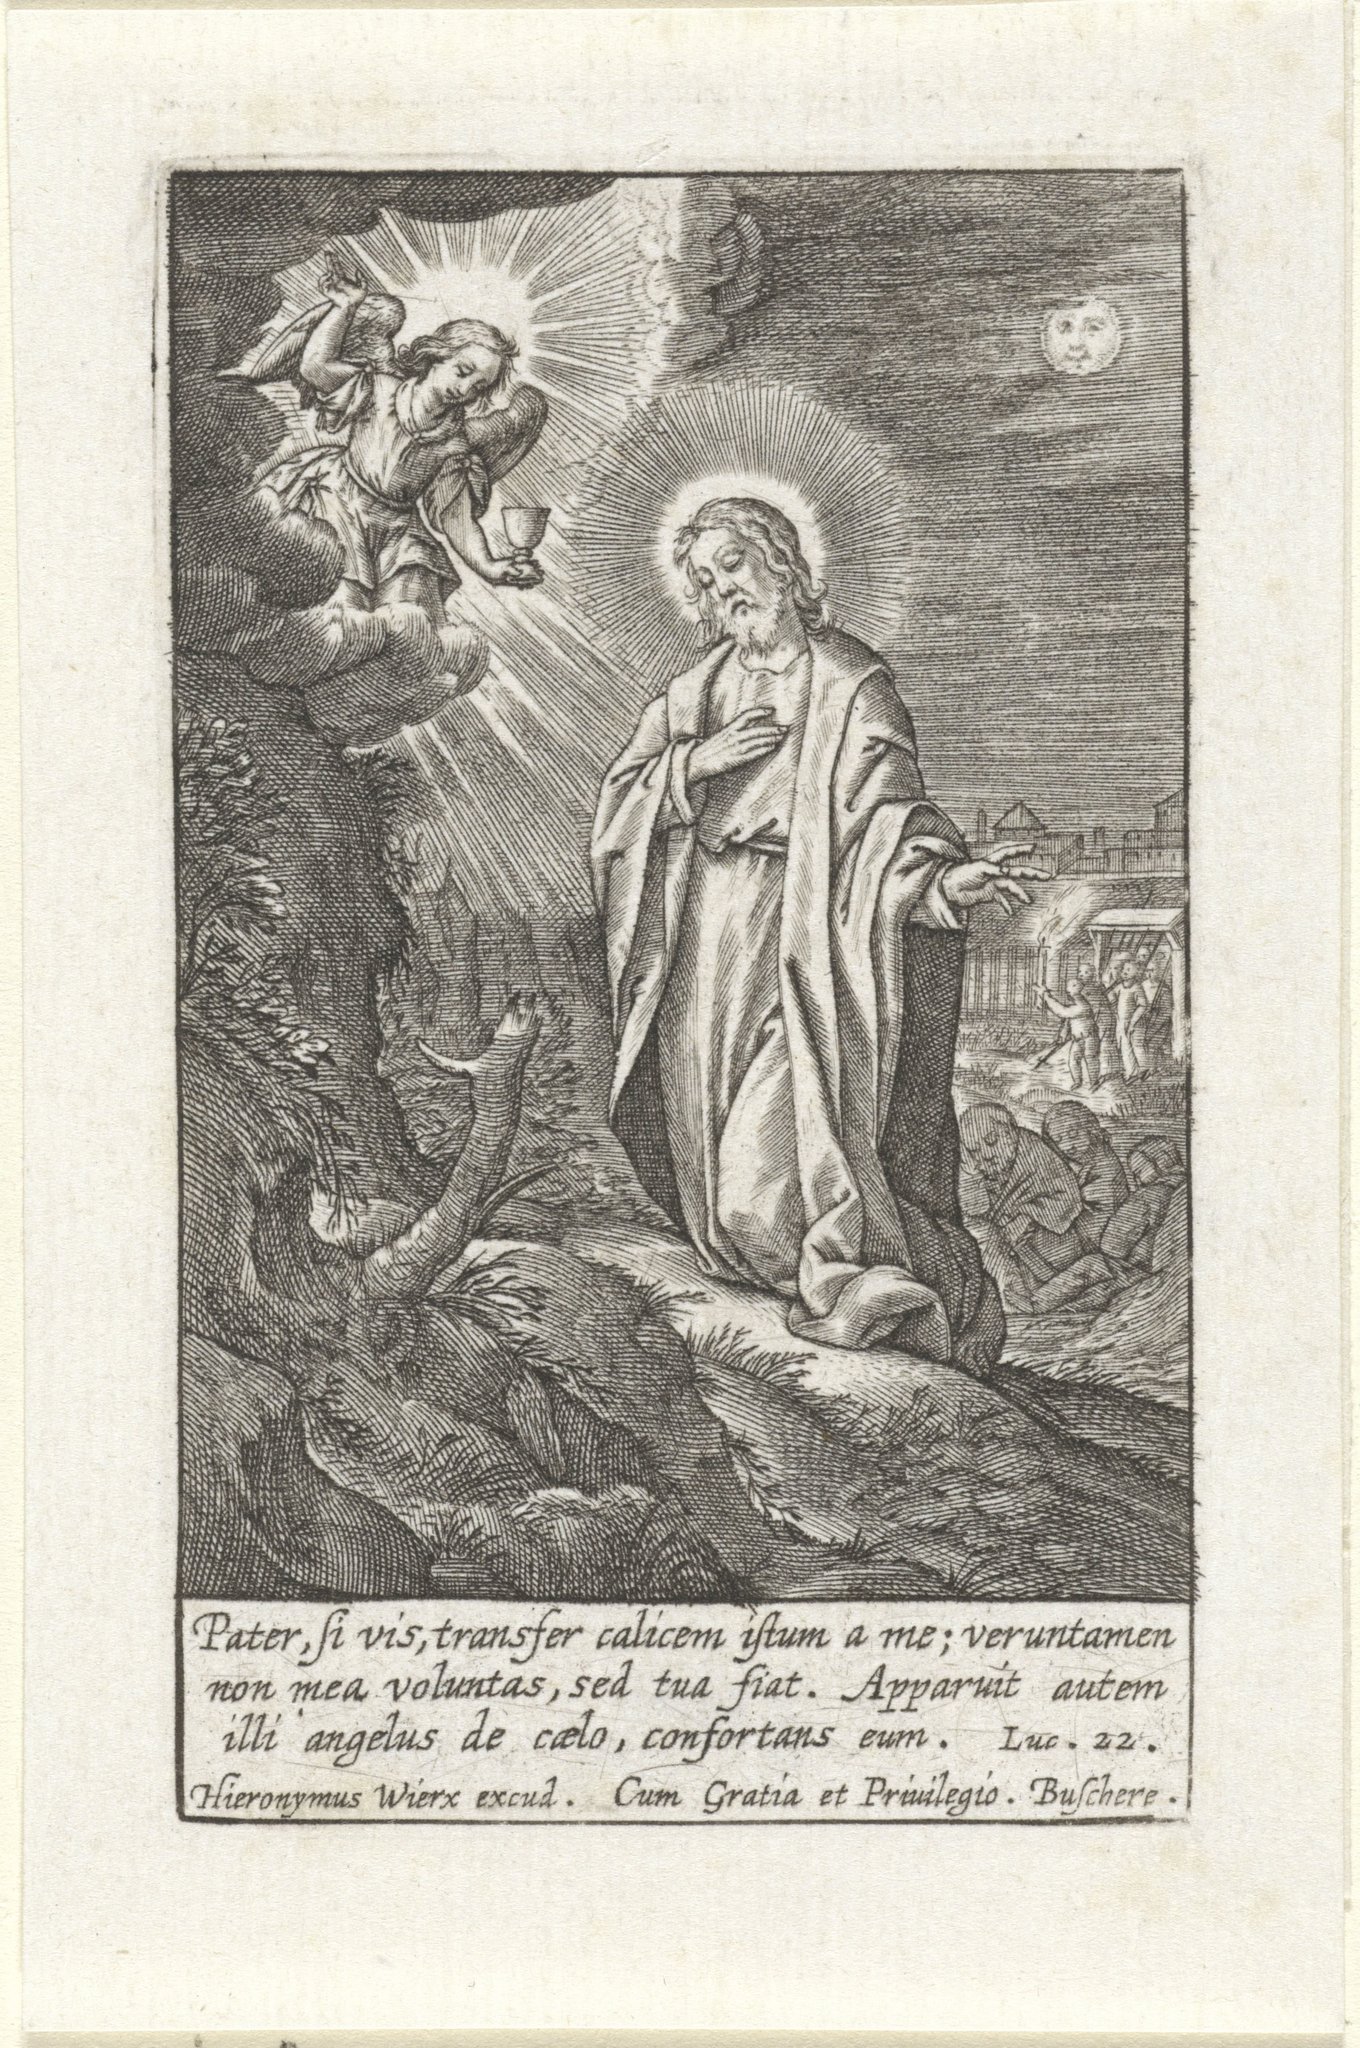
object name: print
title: Passie van Christus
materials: paper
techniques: engraving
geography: antwerp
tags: christ's prayer in the garden of gethsemane during the night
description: Christus bidt in de hof van Getsemane. Uit de hemel verschijnt een engel met een kelk. Zijn leerlingen liggen te slapen op de achtergrond. Judas komt de tuin binnen door de poort en wijst de soldaten de plek waar Christus bidt. In de marge een drieregelig Bijbelcitaat uit Luc. 22 in het Latijn.